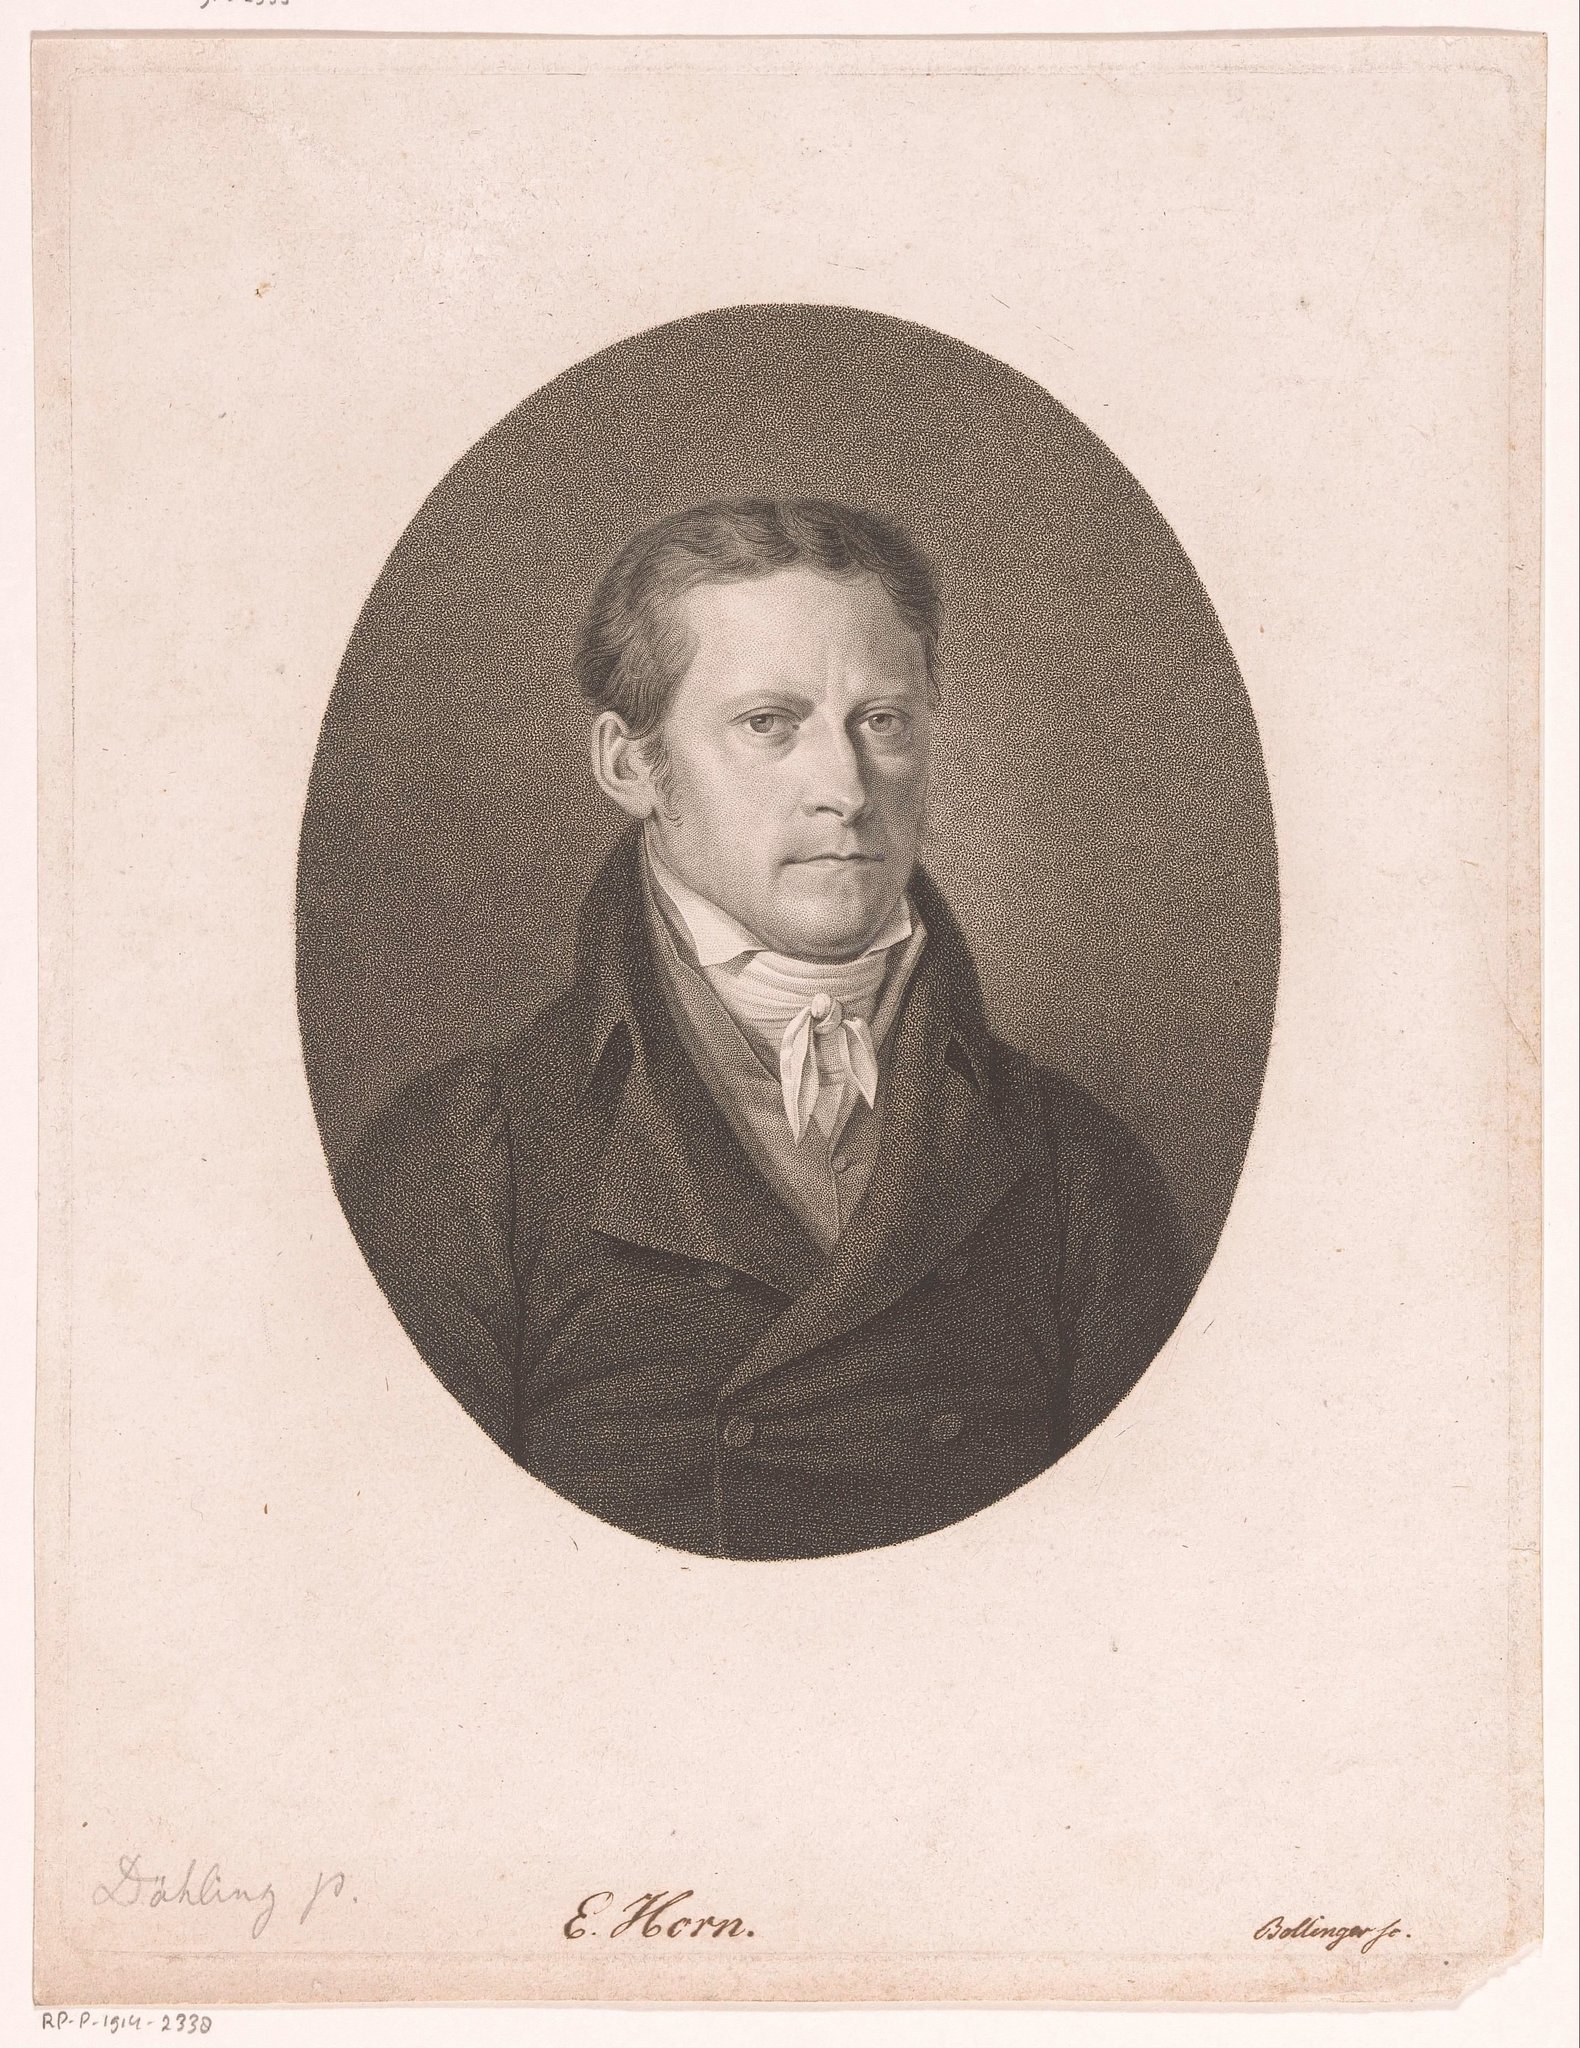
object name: print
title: Portret van Ernst Horn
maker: friedrich wilhelm bollinger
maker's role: print maker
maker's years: 1777-1825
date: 1816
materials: paper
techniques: stippling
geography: berlin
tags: ernst horn, historical persons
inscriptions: collector's mark: Lugt 2228